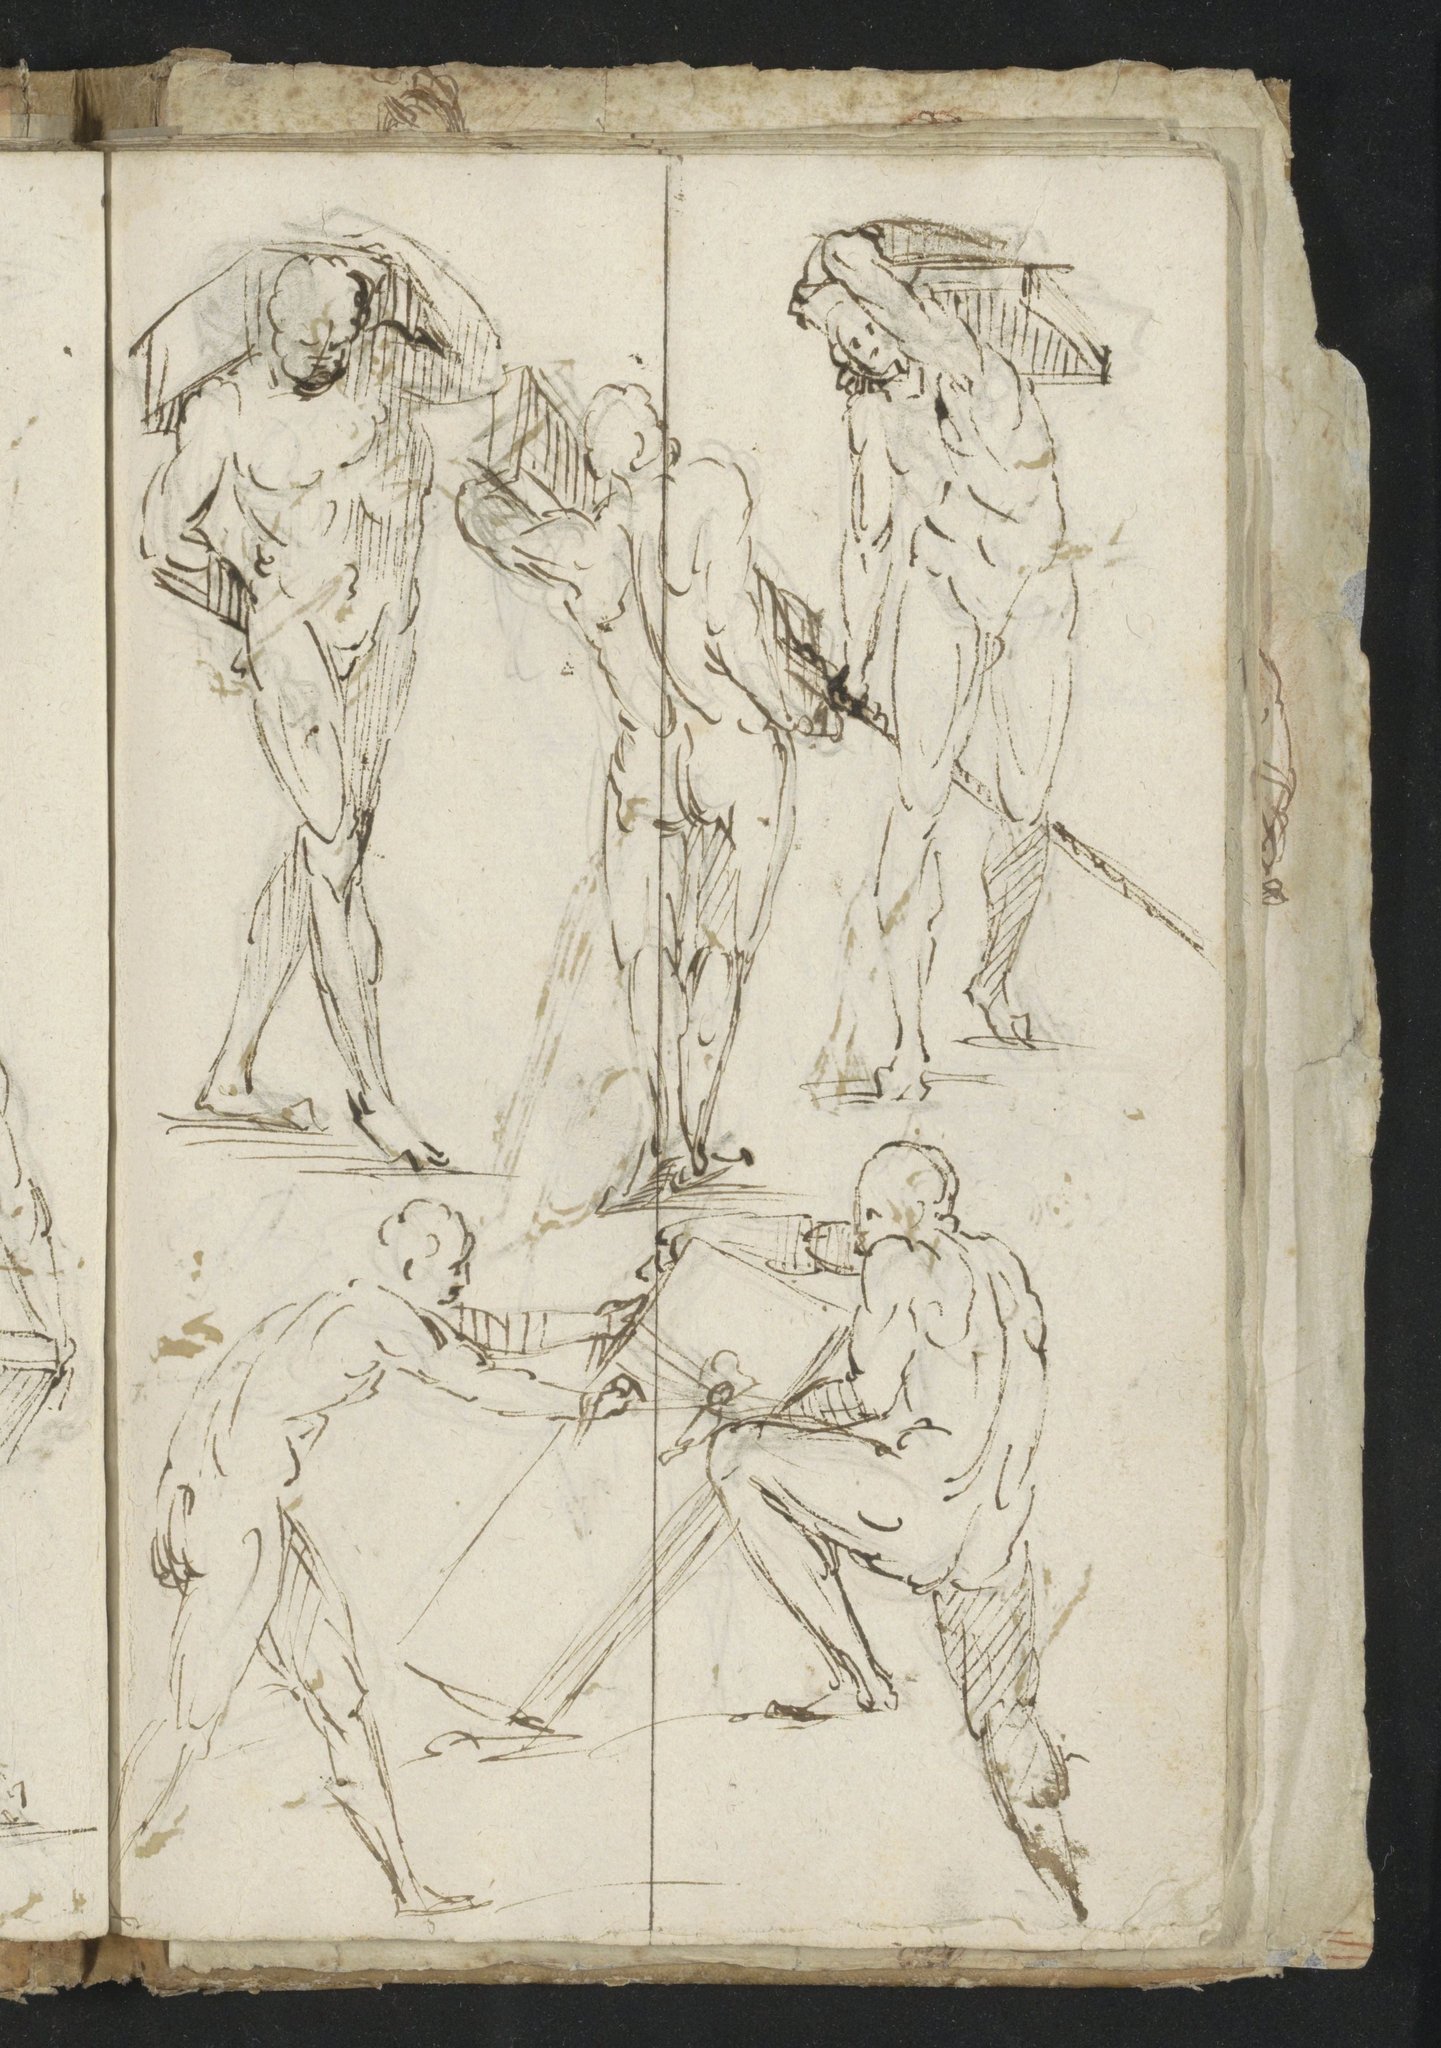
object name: sketchbook leaf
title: Mannen die lasten dragen in verschillende houdingen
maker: Anonymous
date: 1658-1728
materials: ink, paper, pencil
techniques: pen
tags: the (nude) human figure; 'corpo humano' (ripa), carrying something on the head or on the shoulders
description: Blad 20 recto uit een schetsboek met 33 bladen.